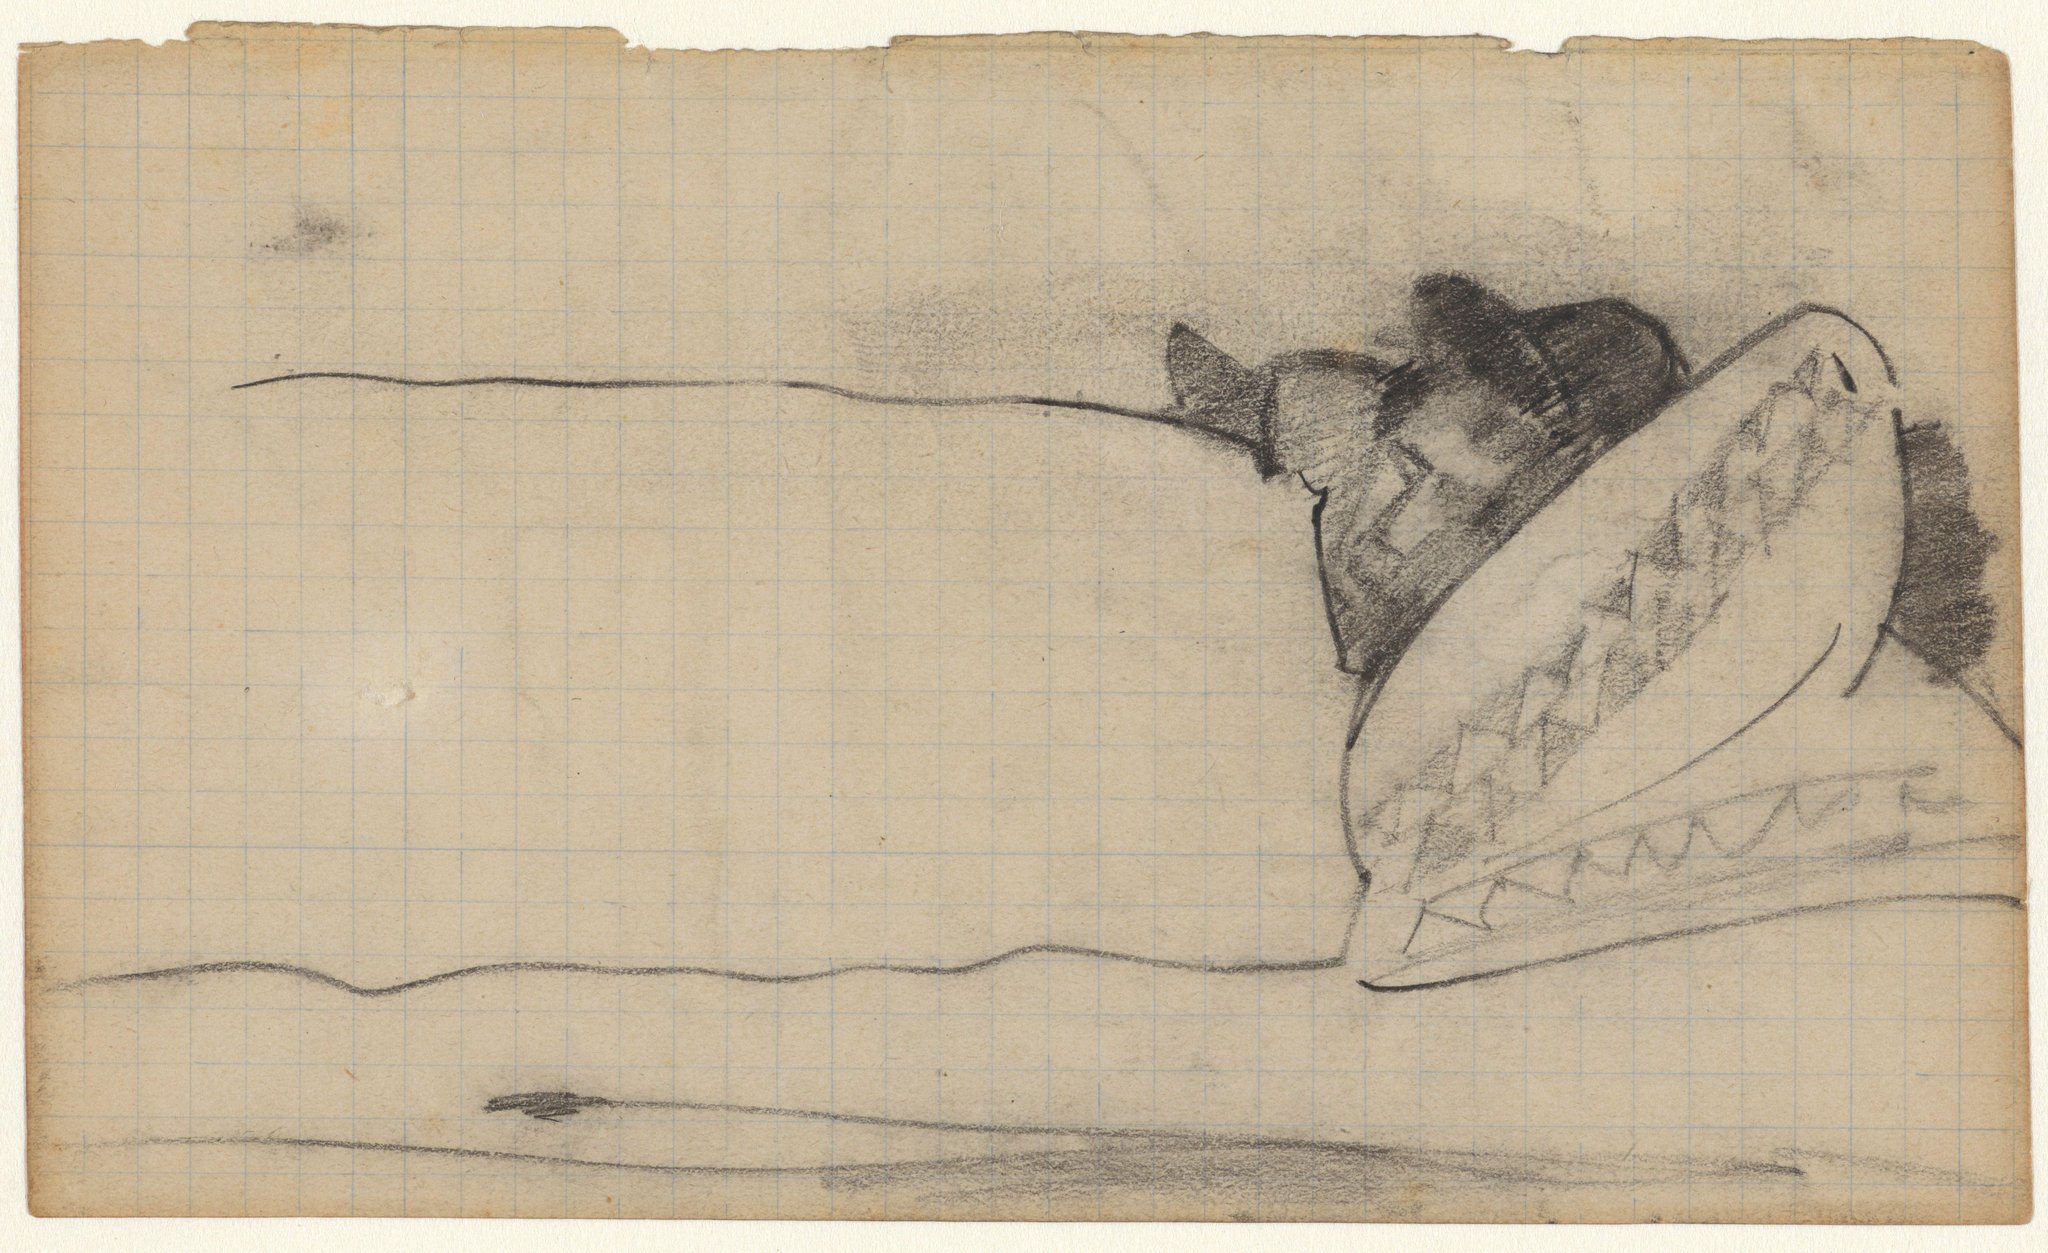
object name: drawing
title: Persoon in bed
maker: theo nieuwenhuis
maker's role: designer, draughtsman, print maker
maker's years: 1866-1951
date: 1876-1951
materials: chalk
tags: bed